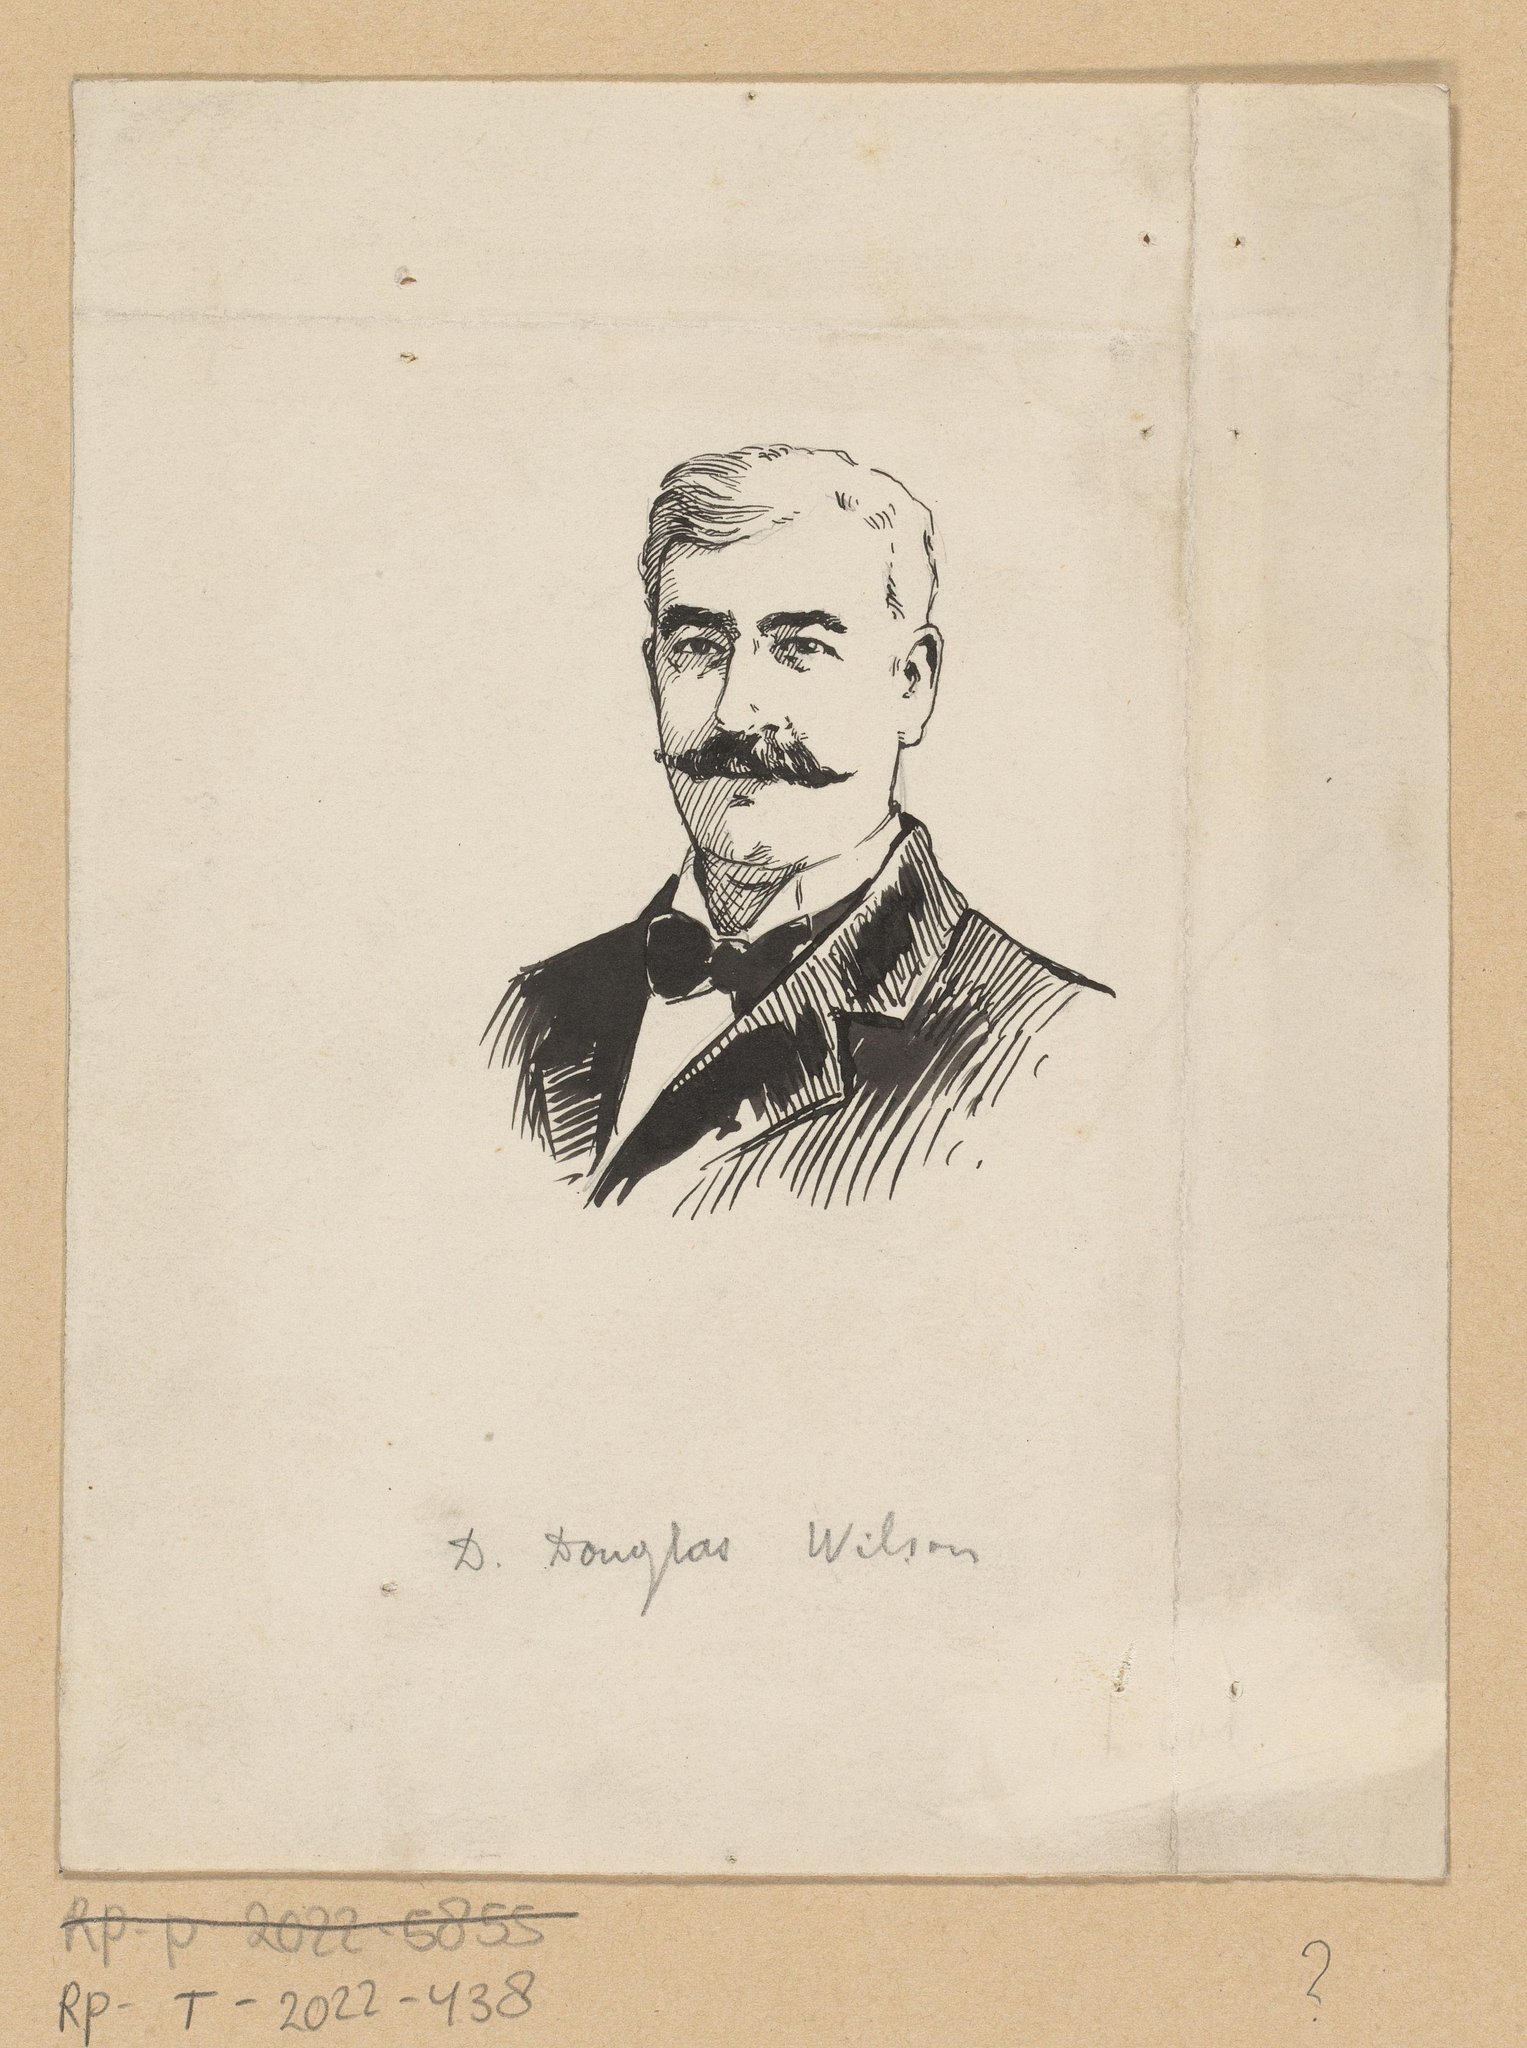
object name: drawing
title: Portret van mogelijk D. Douglas Wilson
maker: Anonymous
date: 1900-2000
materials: ink, paper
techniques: brush, pen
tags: historical persons